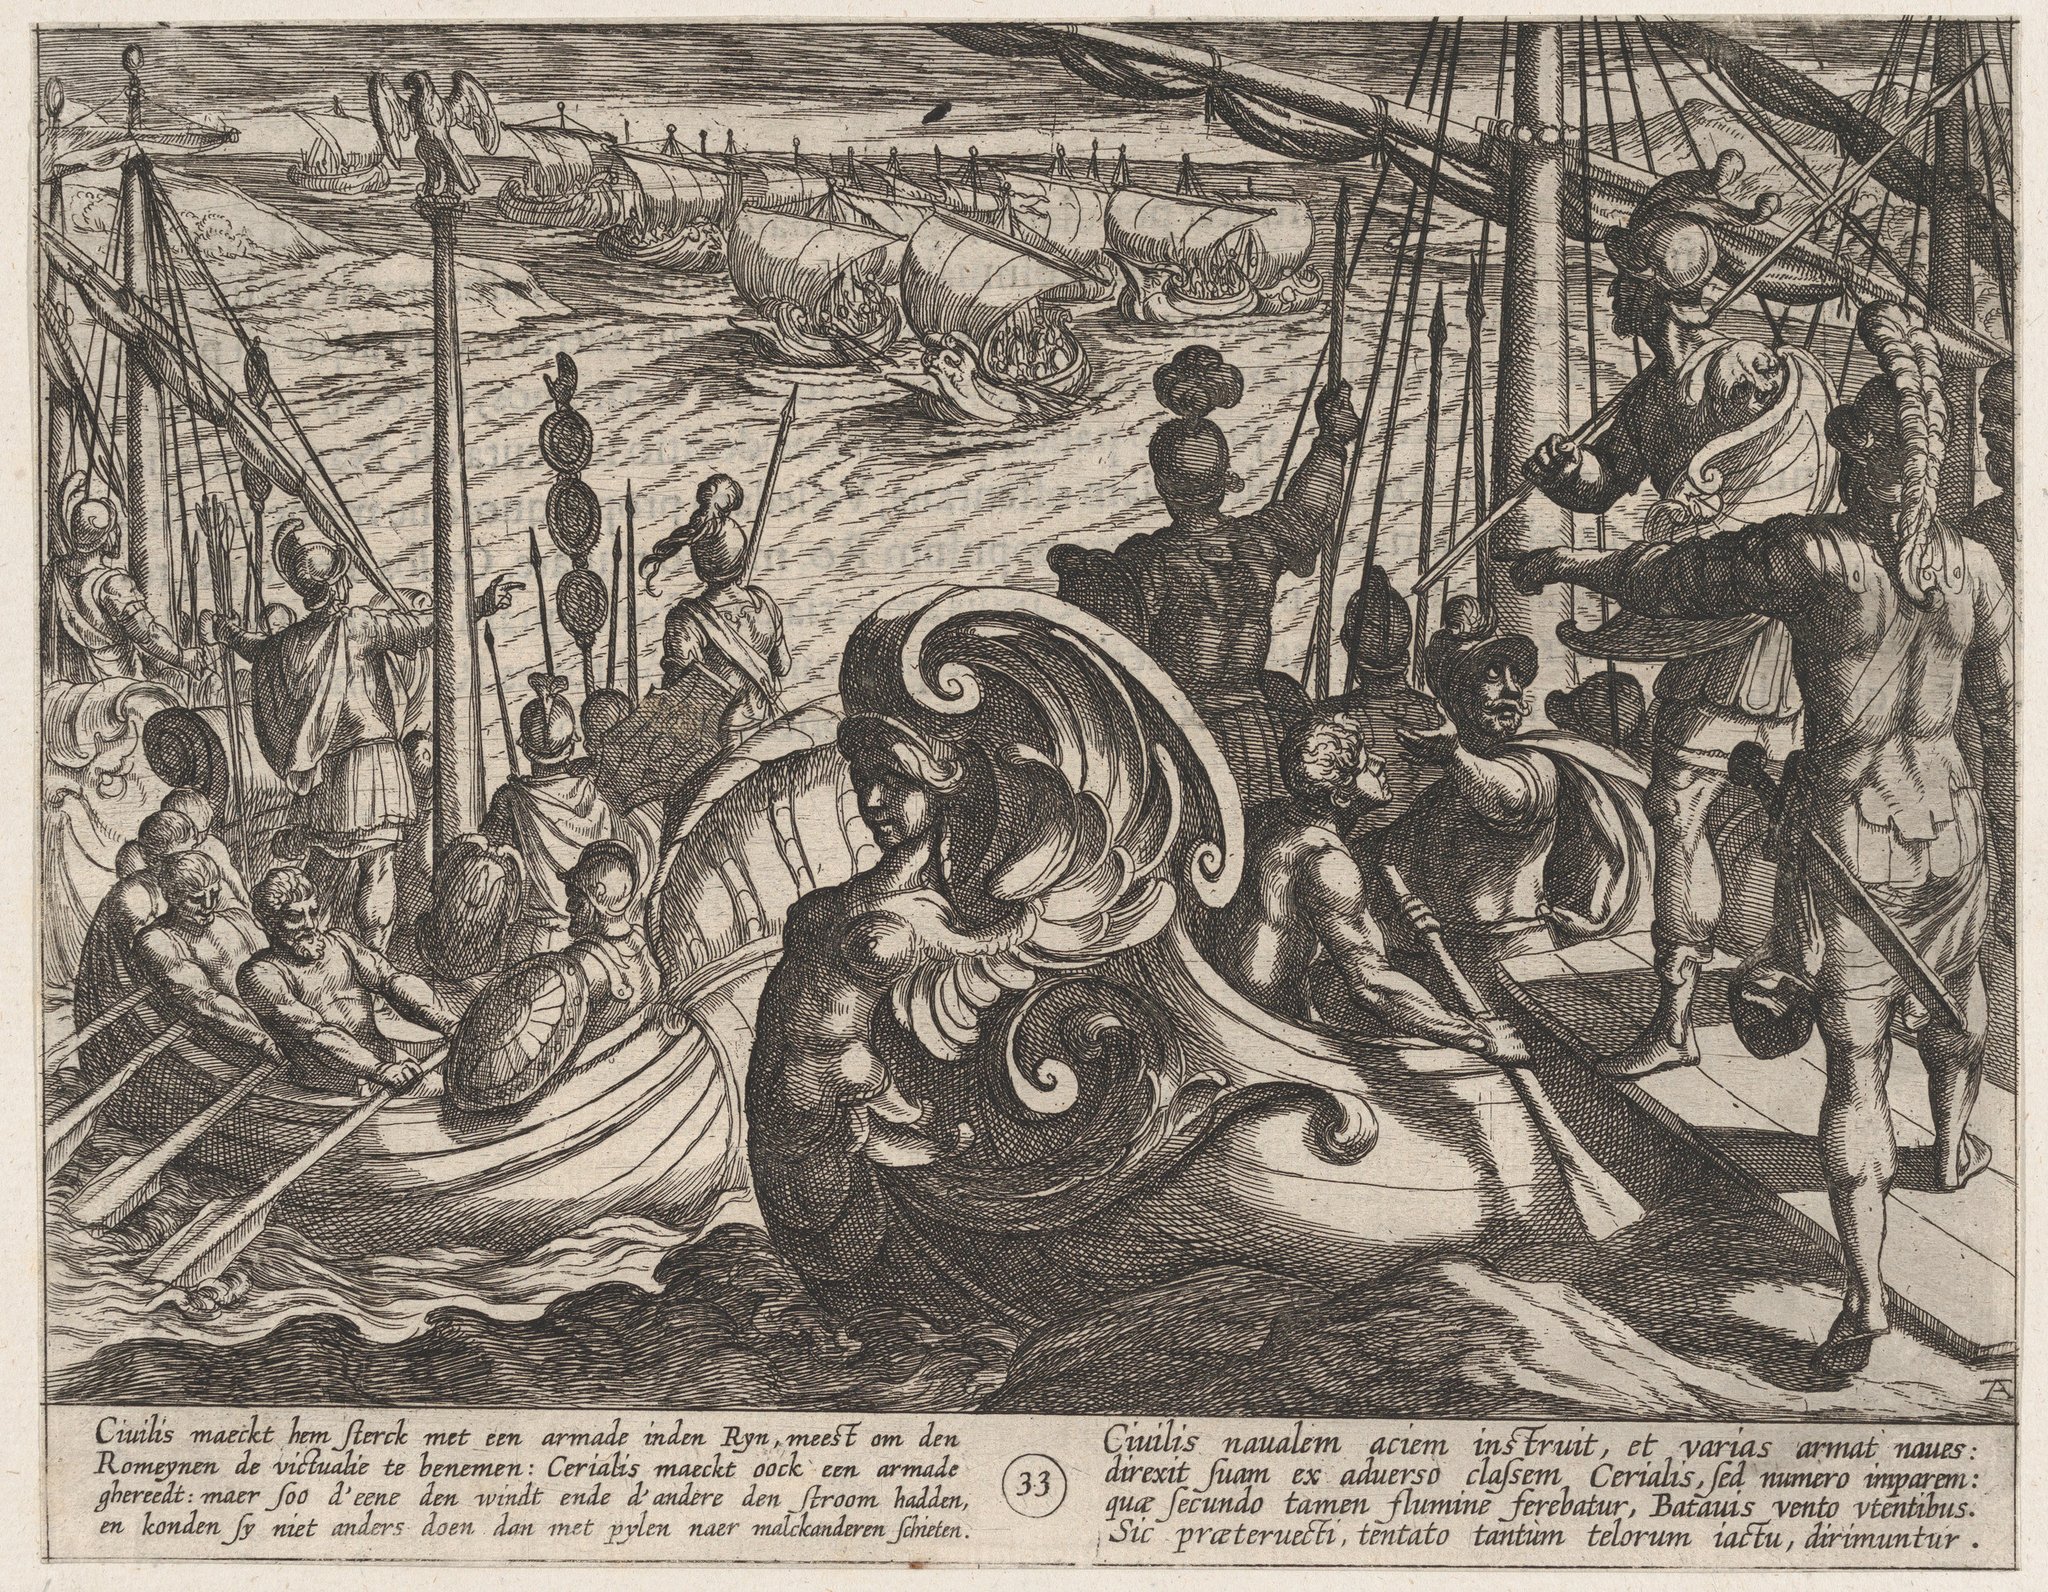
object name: print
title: Plate 33: Dutch and Roman Flotillas on the Rhine, from The War of the Romans Against the Batavians (Romanorvm et Batavorvm societas)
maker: antonio tempesta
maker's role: artist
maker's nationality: italian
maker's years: 1555-1630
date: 1611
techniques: etching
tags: battles,navy,boats